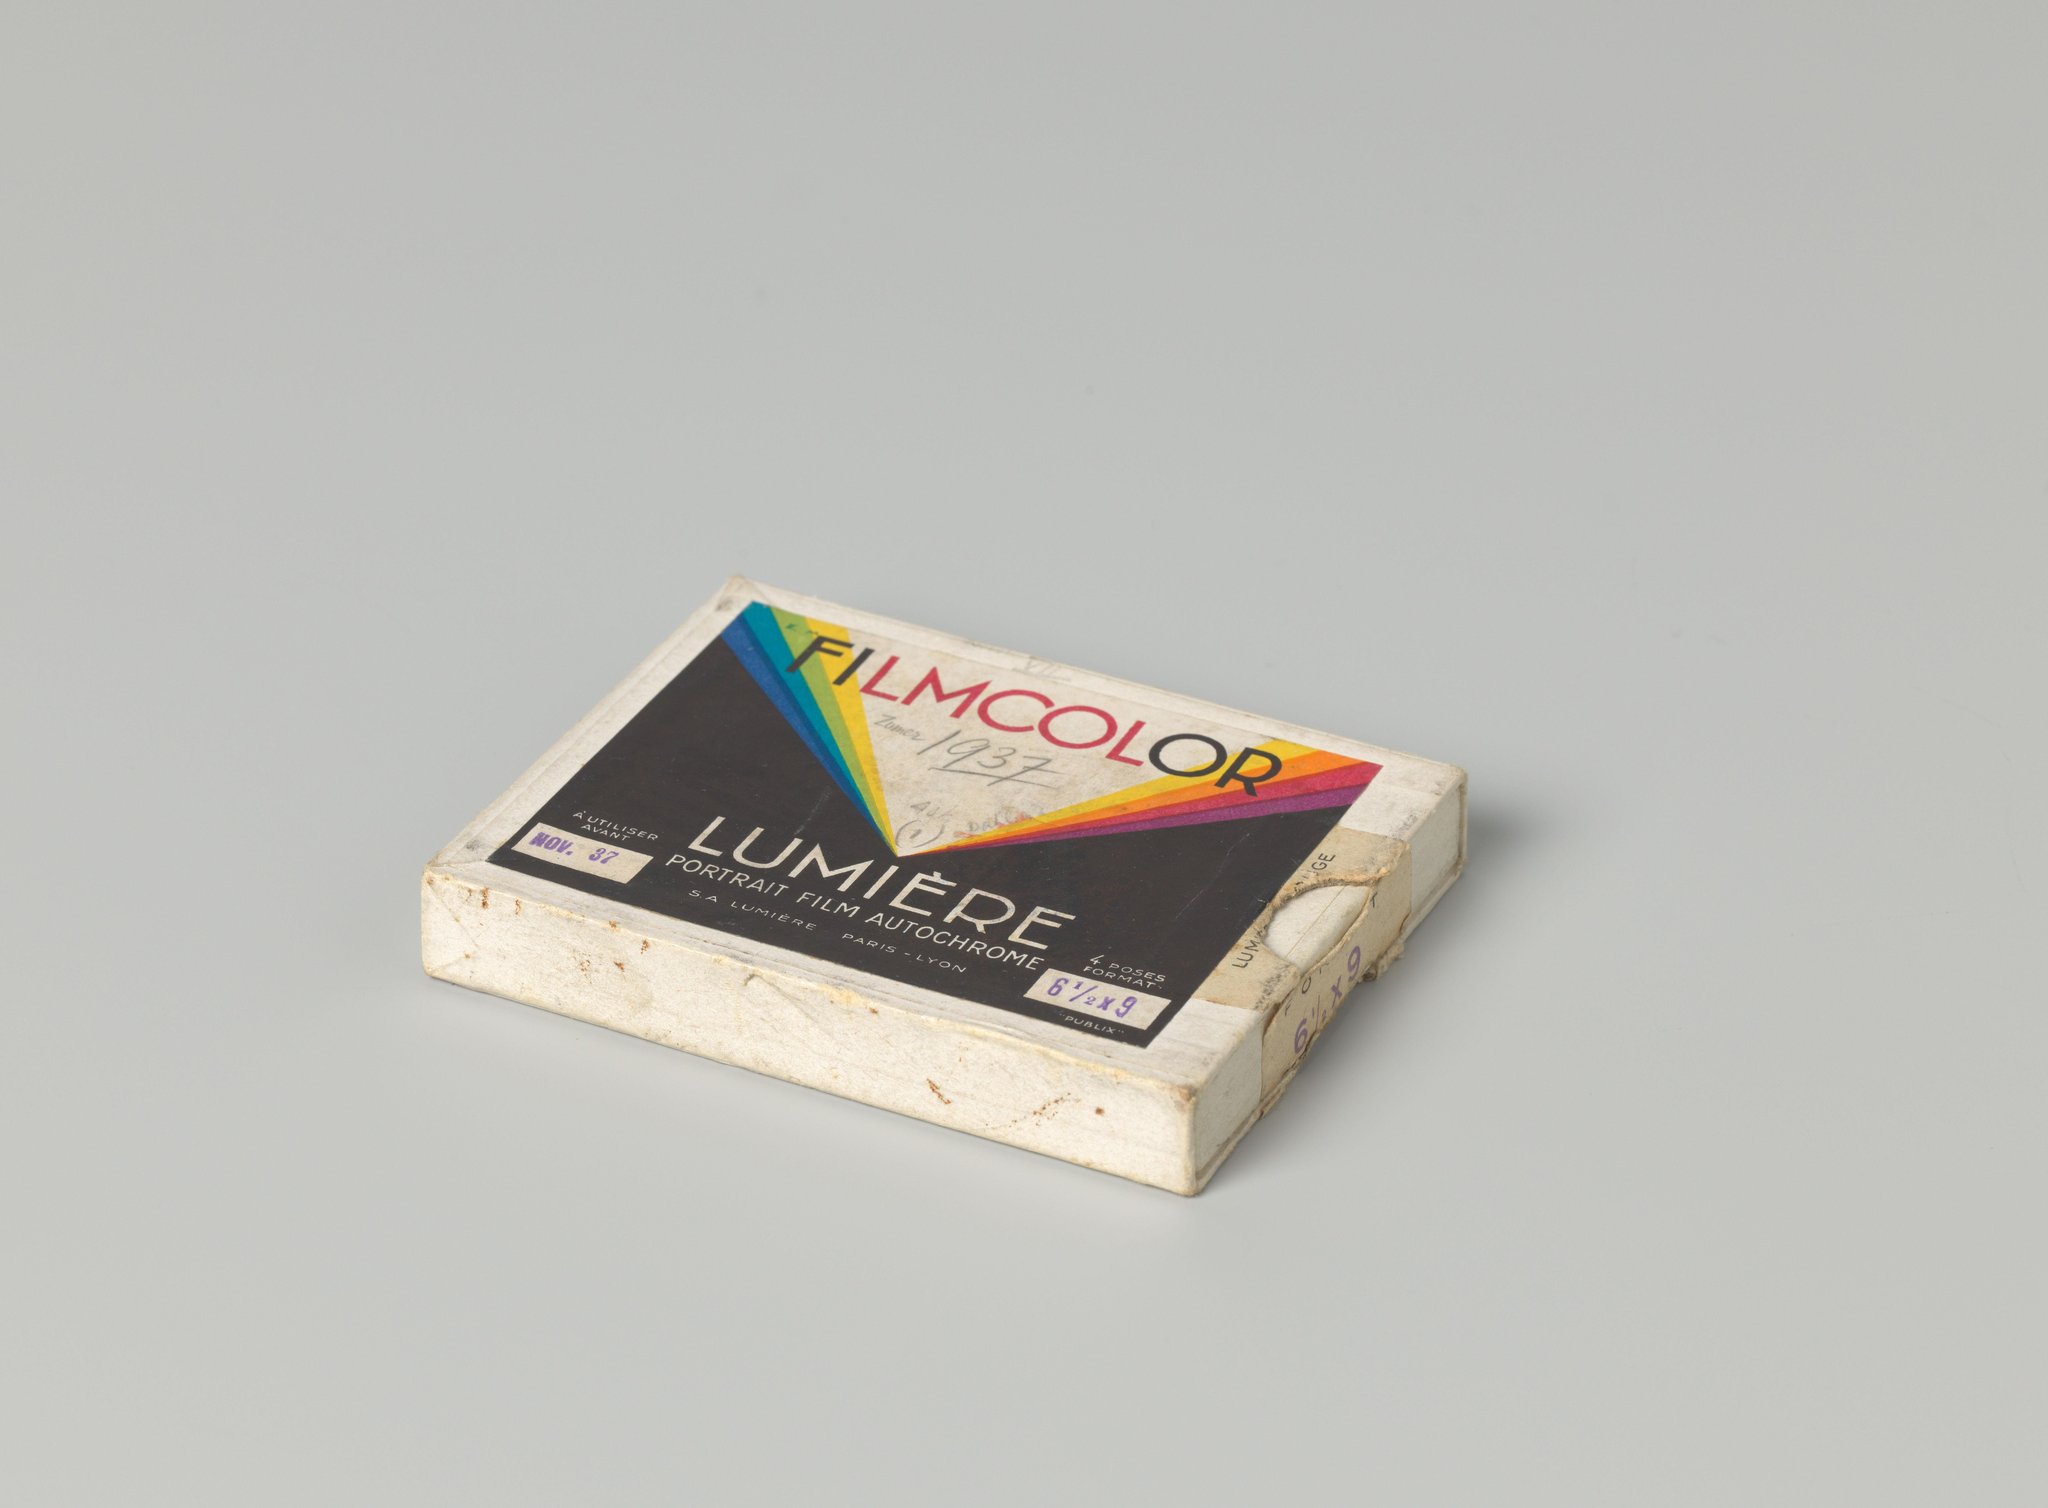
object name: box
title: Doos voor autochromes van Lumière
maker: lumière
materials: cardboard, paper, tape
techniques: printing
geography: france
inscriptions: date: ‘À UTILISER/ AVANT/ NOV. 37’, inscription: ‘VII/ Zomer 1937/ 4st/ (1)’